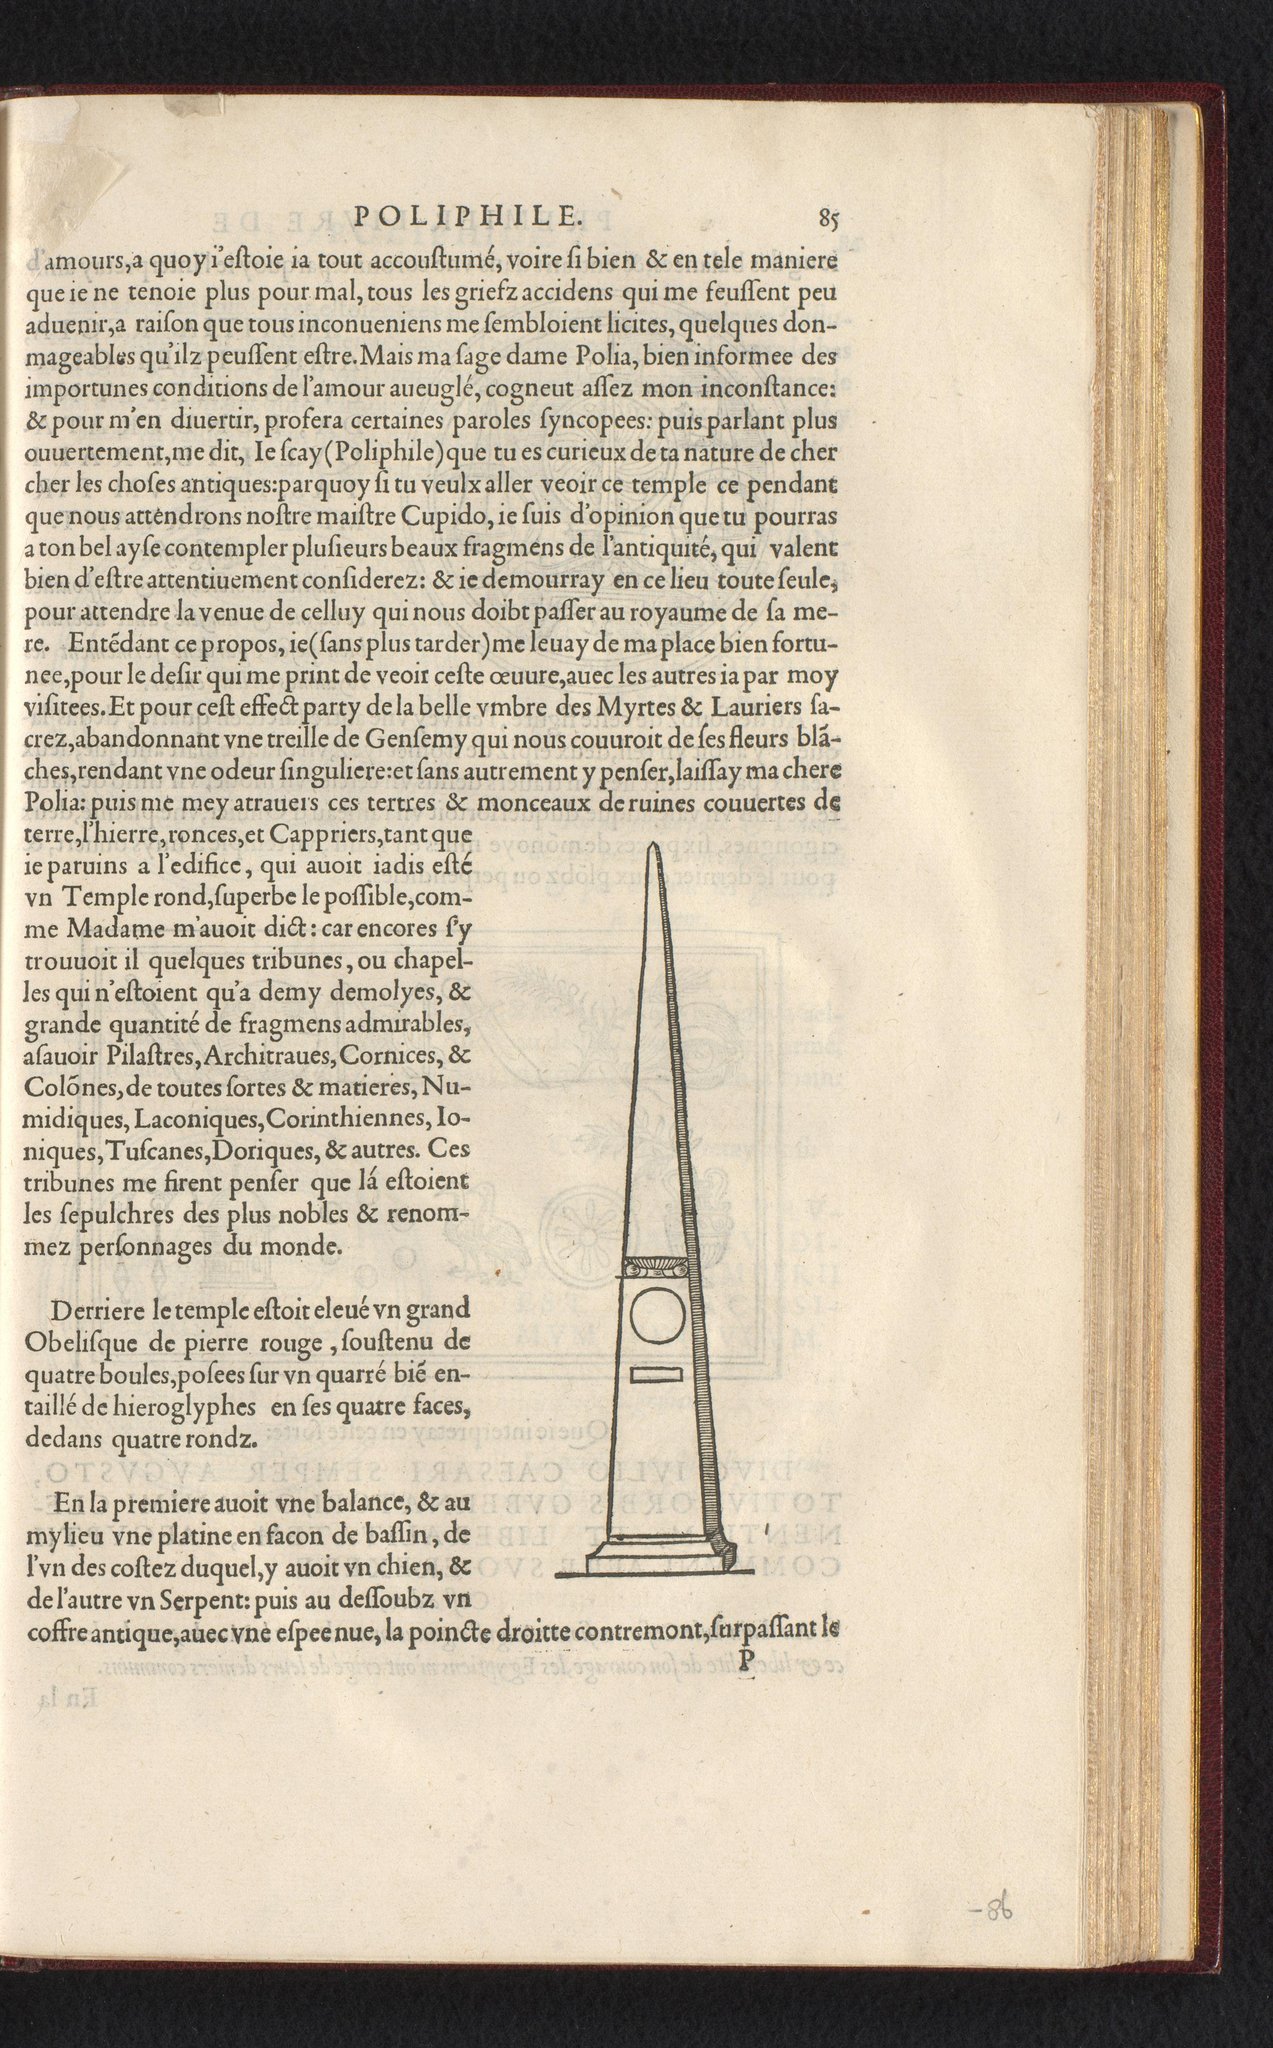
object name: book illustration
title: Obelisk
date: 1546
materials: paper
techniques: letterpress printing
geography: paris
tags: obelisk, needle, (scenes from) specific works of literature: colonna, hypnerotomachia poliphili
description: Prent uit: Colonna, Francesco. Hypnerotomachie ou discours du songe de Poliphile, deduisant comme amour le combat a l'occasion de Polia. Parijs: Jacques Kerver, 1546, recto fol. 85.